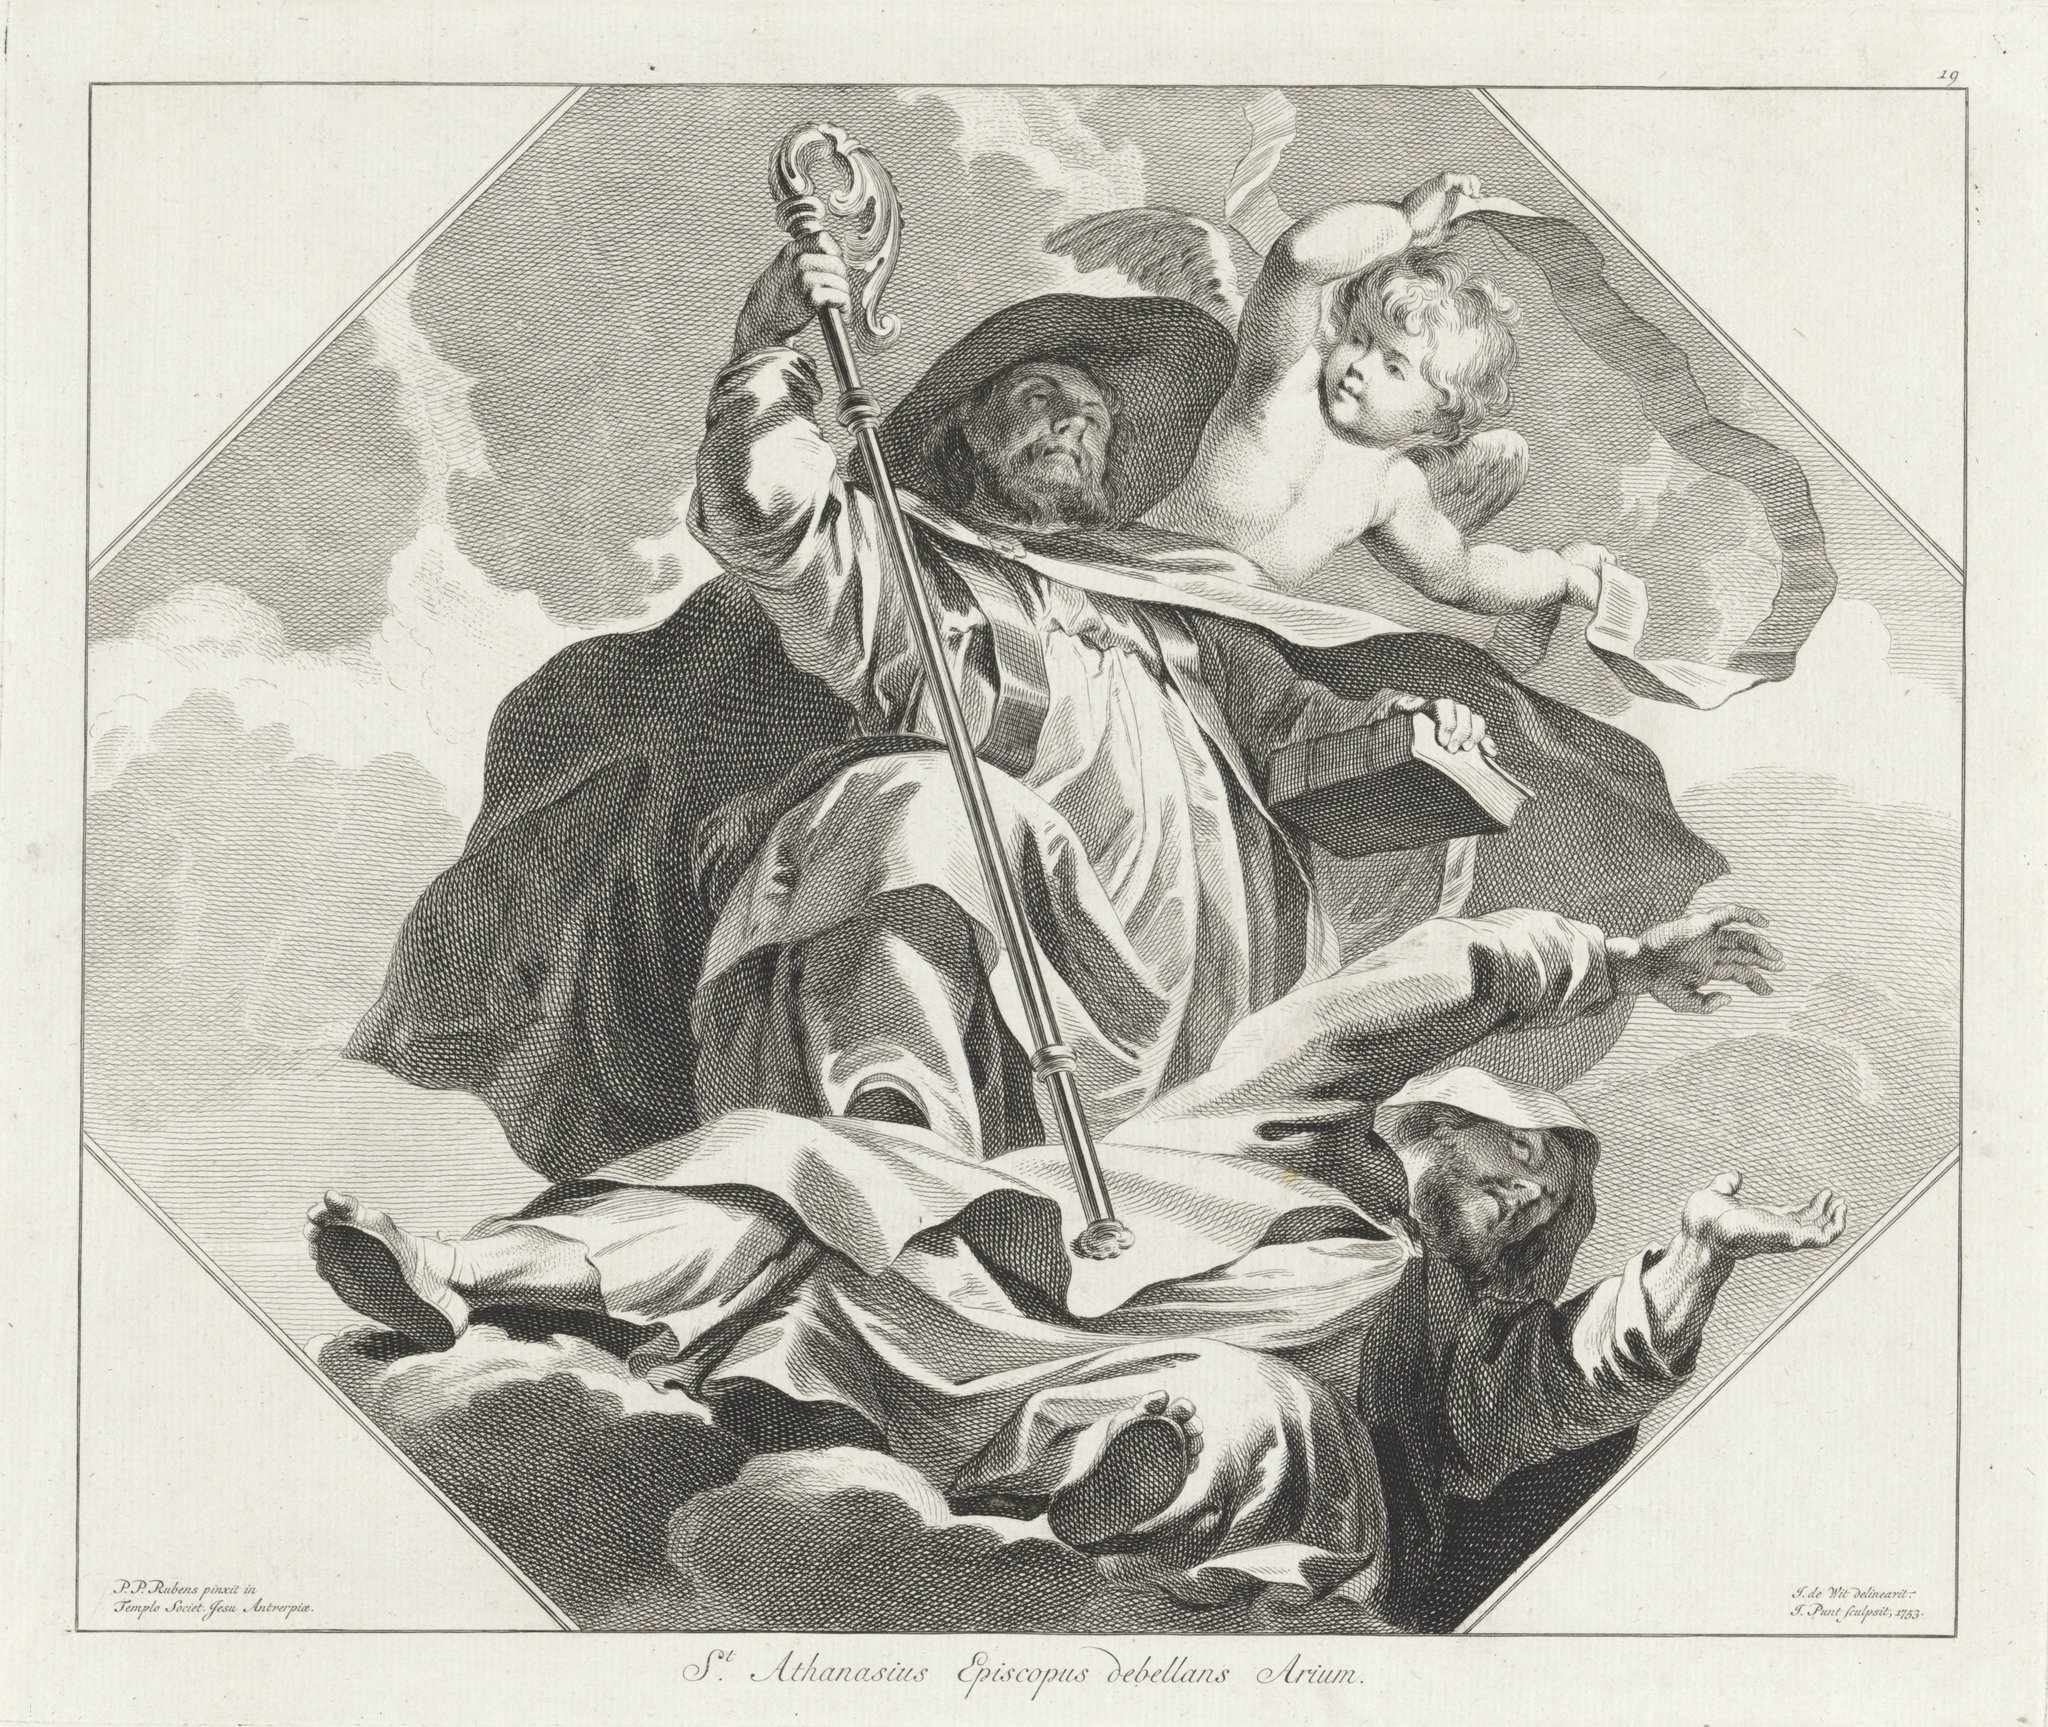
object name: print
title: Bisschop Athanasius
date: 1753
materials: paper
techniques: engraving, etching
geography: amsterdam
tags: athanasius the great, bishop of alexandria; possible attributes: book, heretic under feet, scroll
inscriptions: collector's mark: Lugt 240, date: ‘1753’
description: Bisschop Athanasius met staf en boek; onder de octagonale voorstelling een tekstregel.